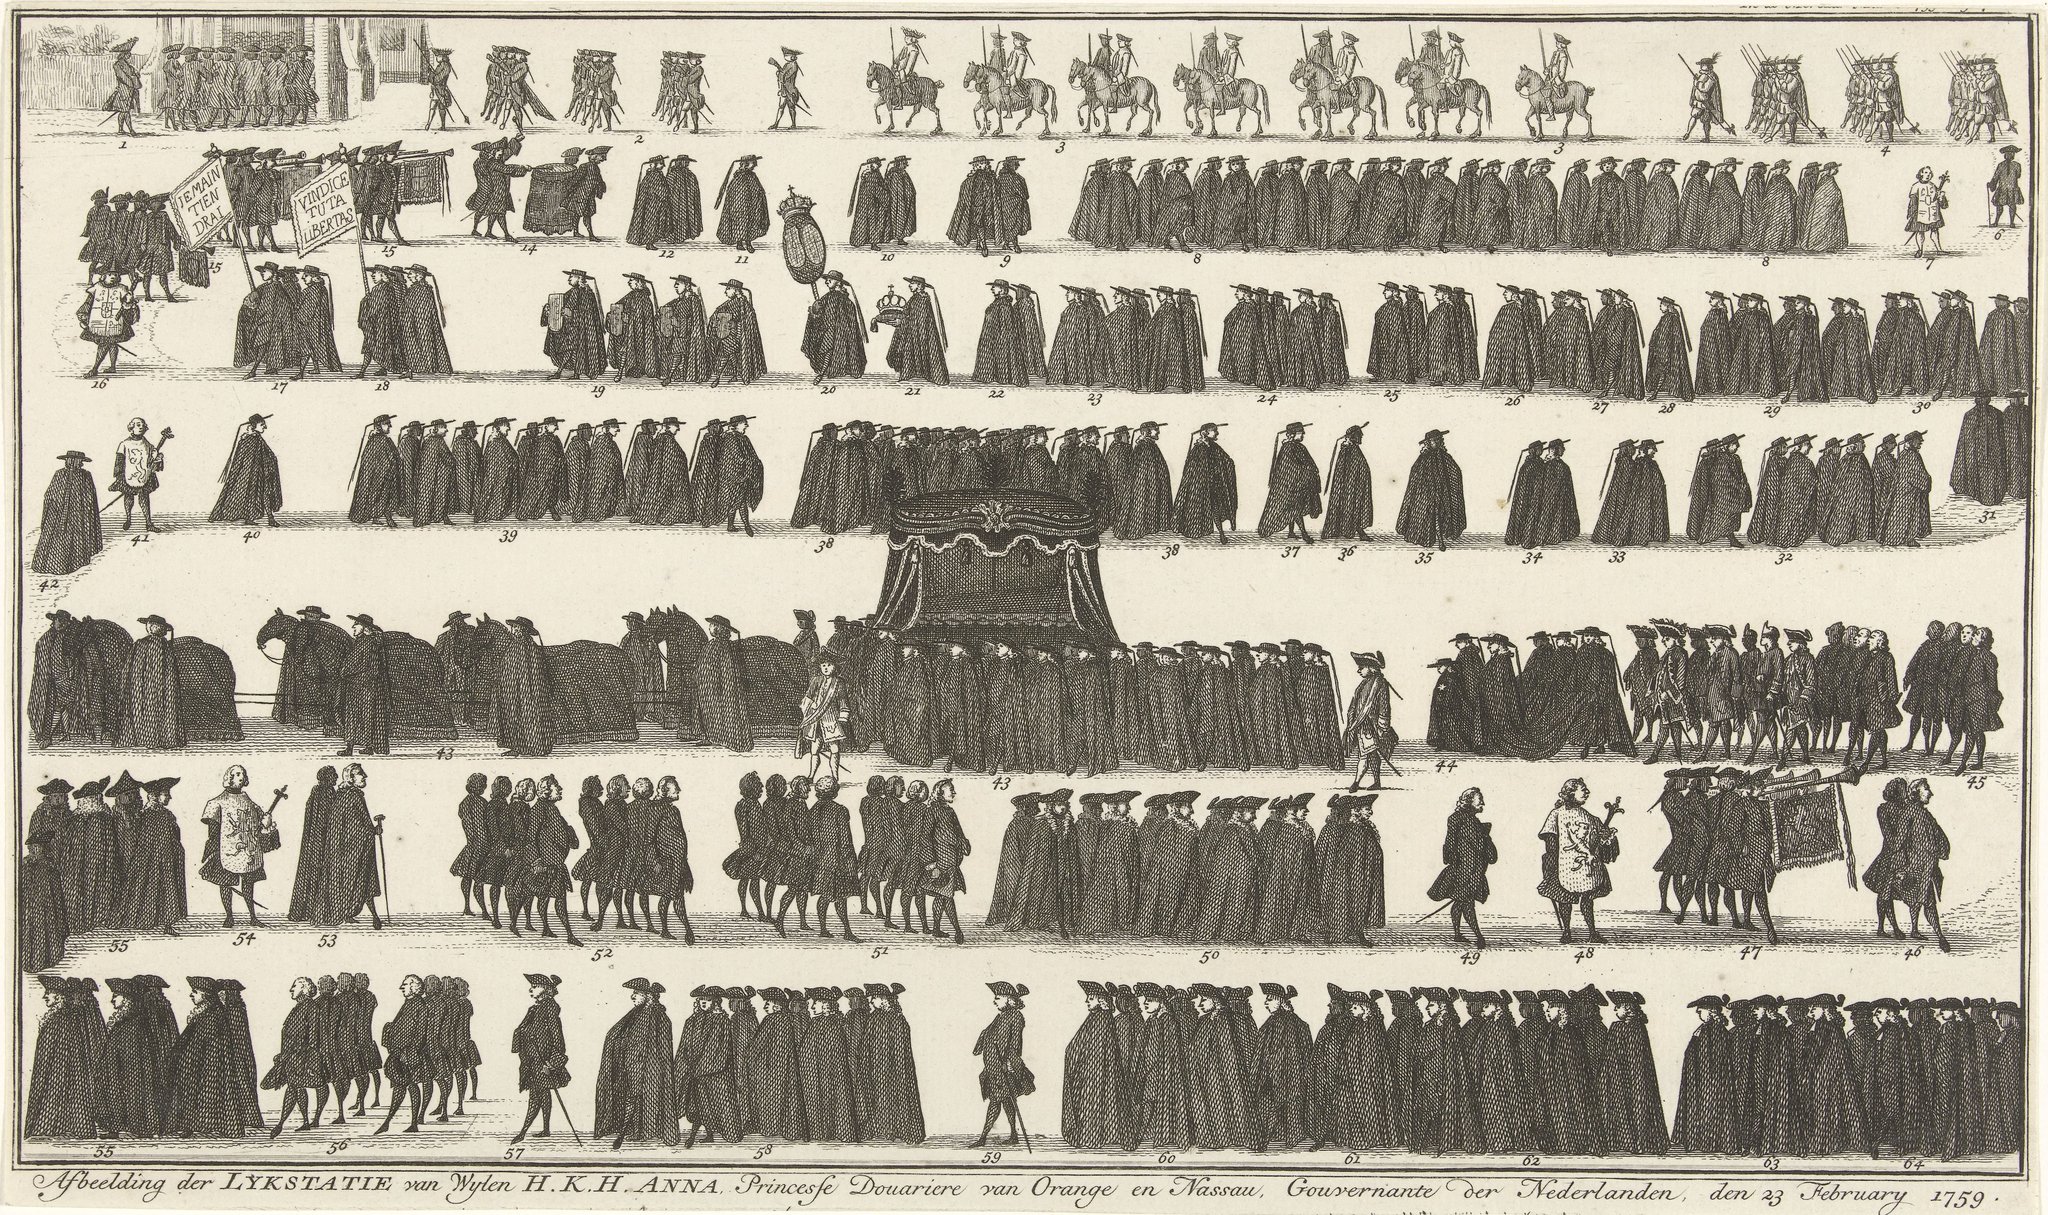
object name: print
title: Afbeelding der Lykstatie van Wylen H.K.H. Anna, Princesse Douariere van Orange en Nassau, Gouvernante der Nederlanden, den 23 February 1759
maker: Anonymous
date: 1759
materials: paper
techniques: etching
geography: northern netherlands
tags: the hague, anna van hannover, cortege, funeral procession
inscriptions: collector's mark: Lugt 2228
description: De lijkstatie van de op 23 februari 1759 te Delft begraven prinses Anna van Hannover. De stoet afgebeeld in zeven rijen onder elkaar. Details in de voorstelling genummerd 1-64.